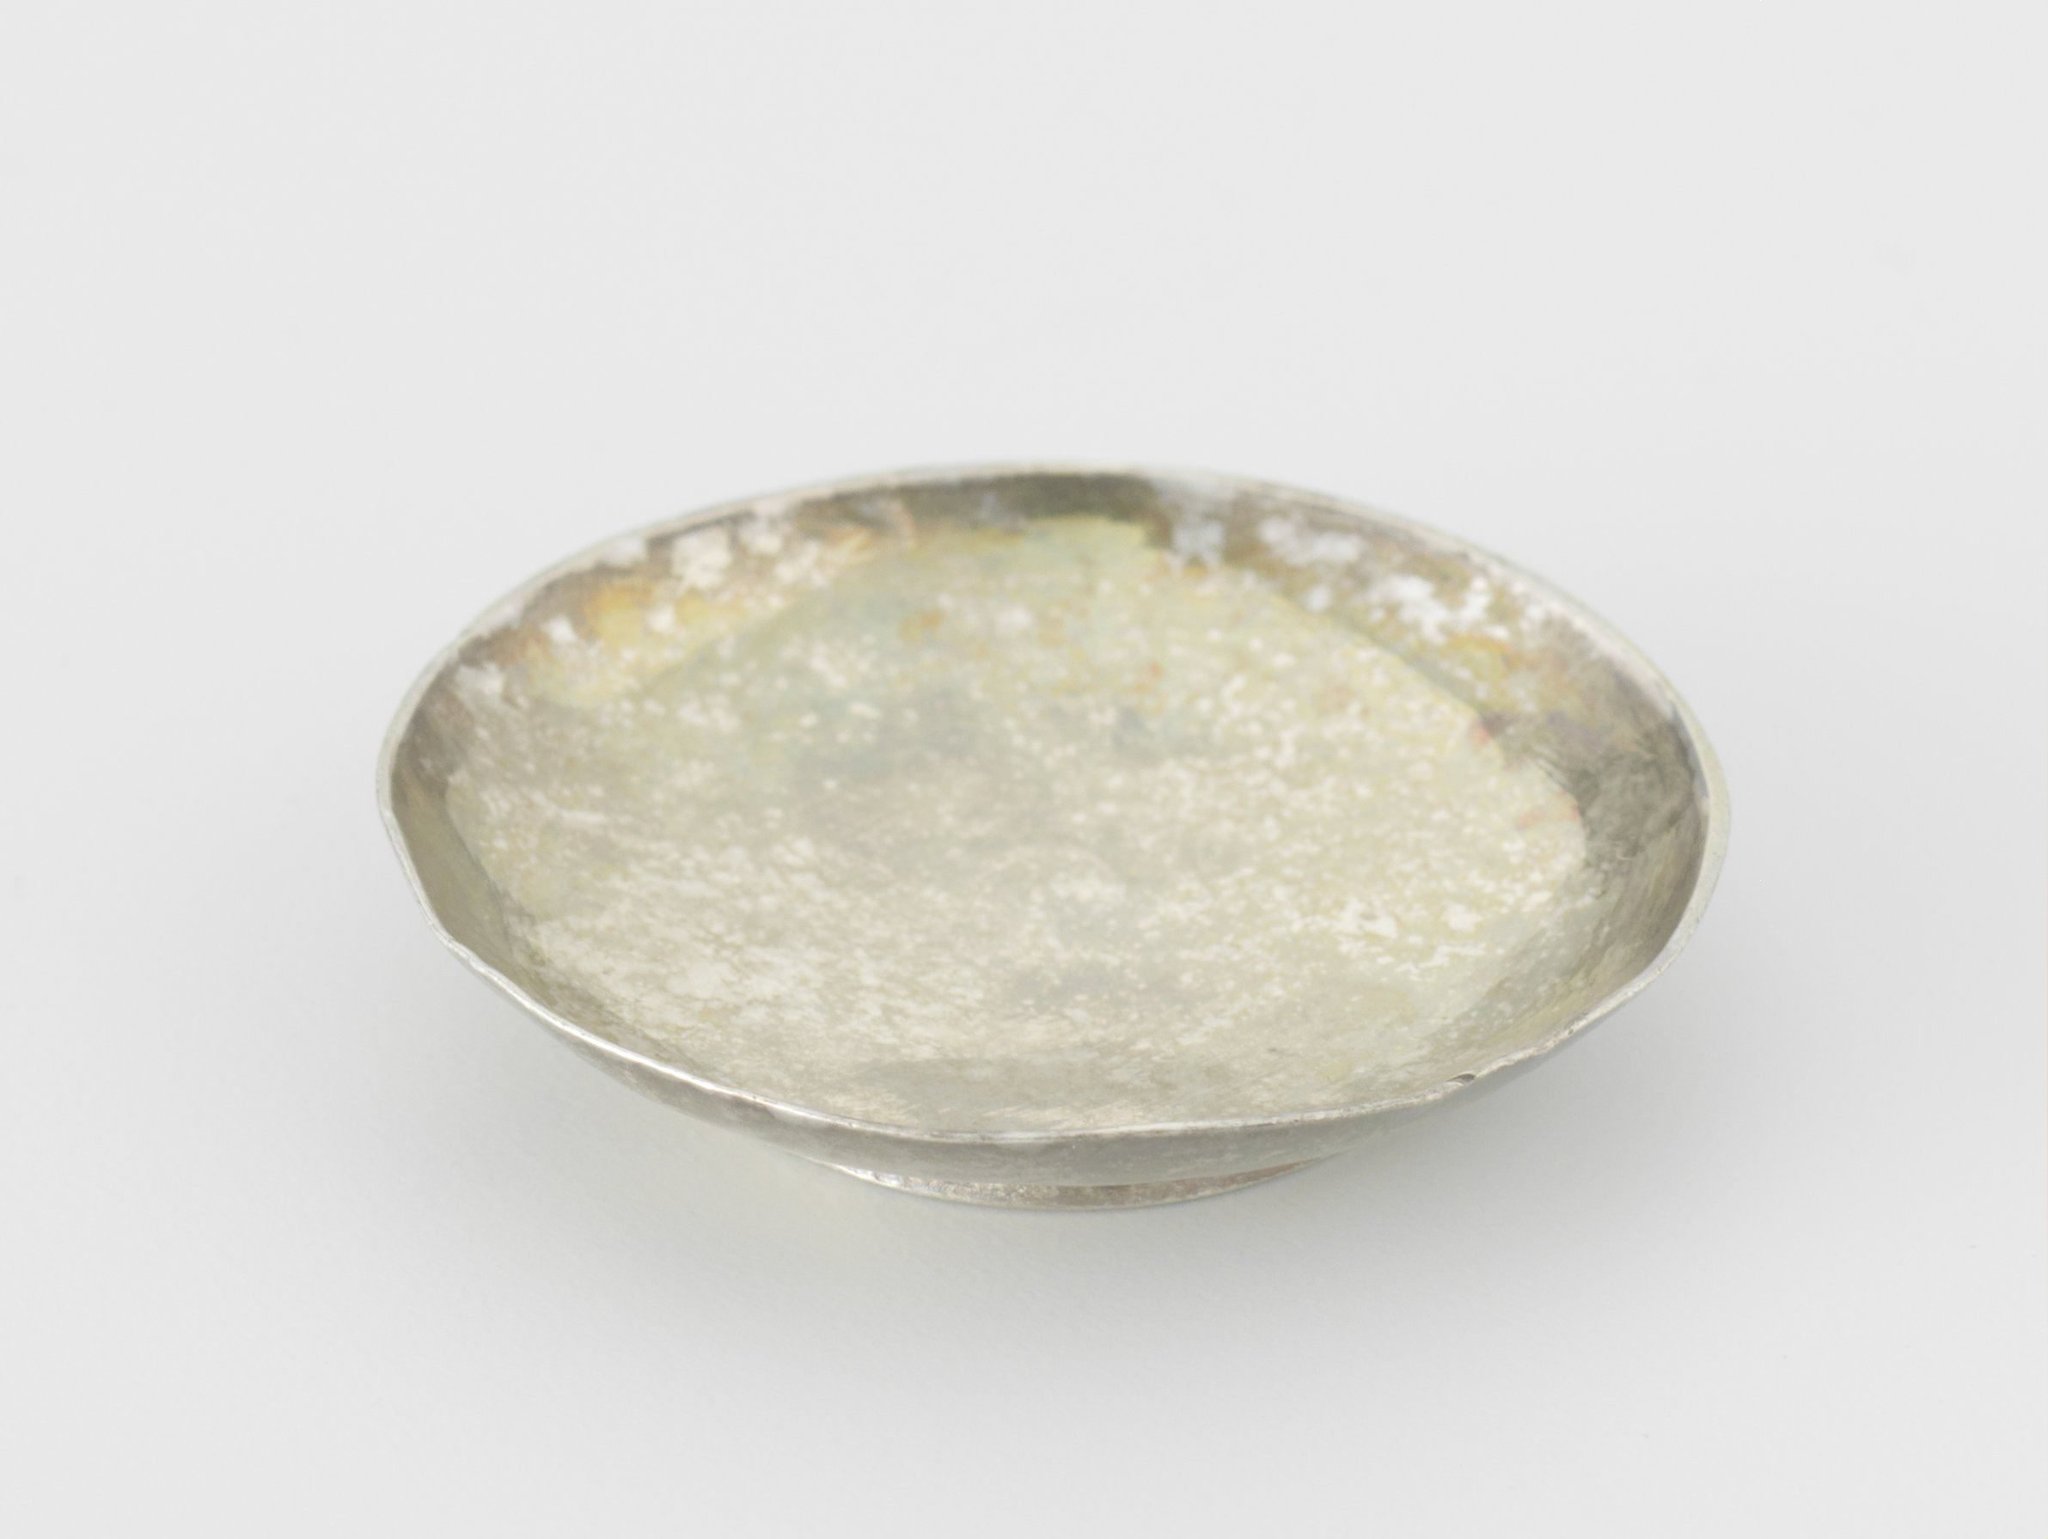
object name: miniature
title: Bord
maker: Anonymous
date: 1730-1760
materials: silver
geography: netherlands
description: Glad rond bord op een standring. Het bord is gemerkt met een letter Z (jrl?) en een onbekend merk. Het bord is gelijk aan het bord met invnr. BK-1977-64-b.